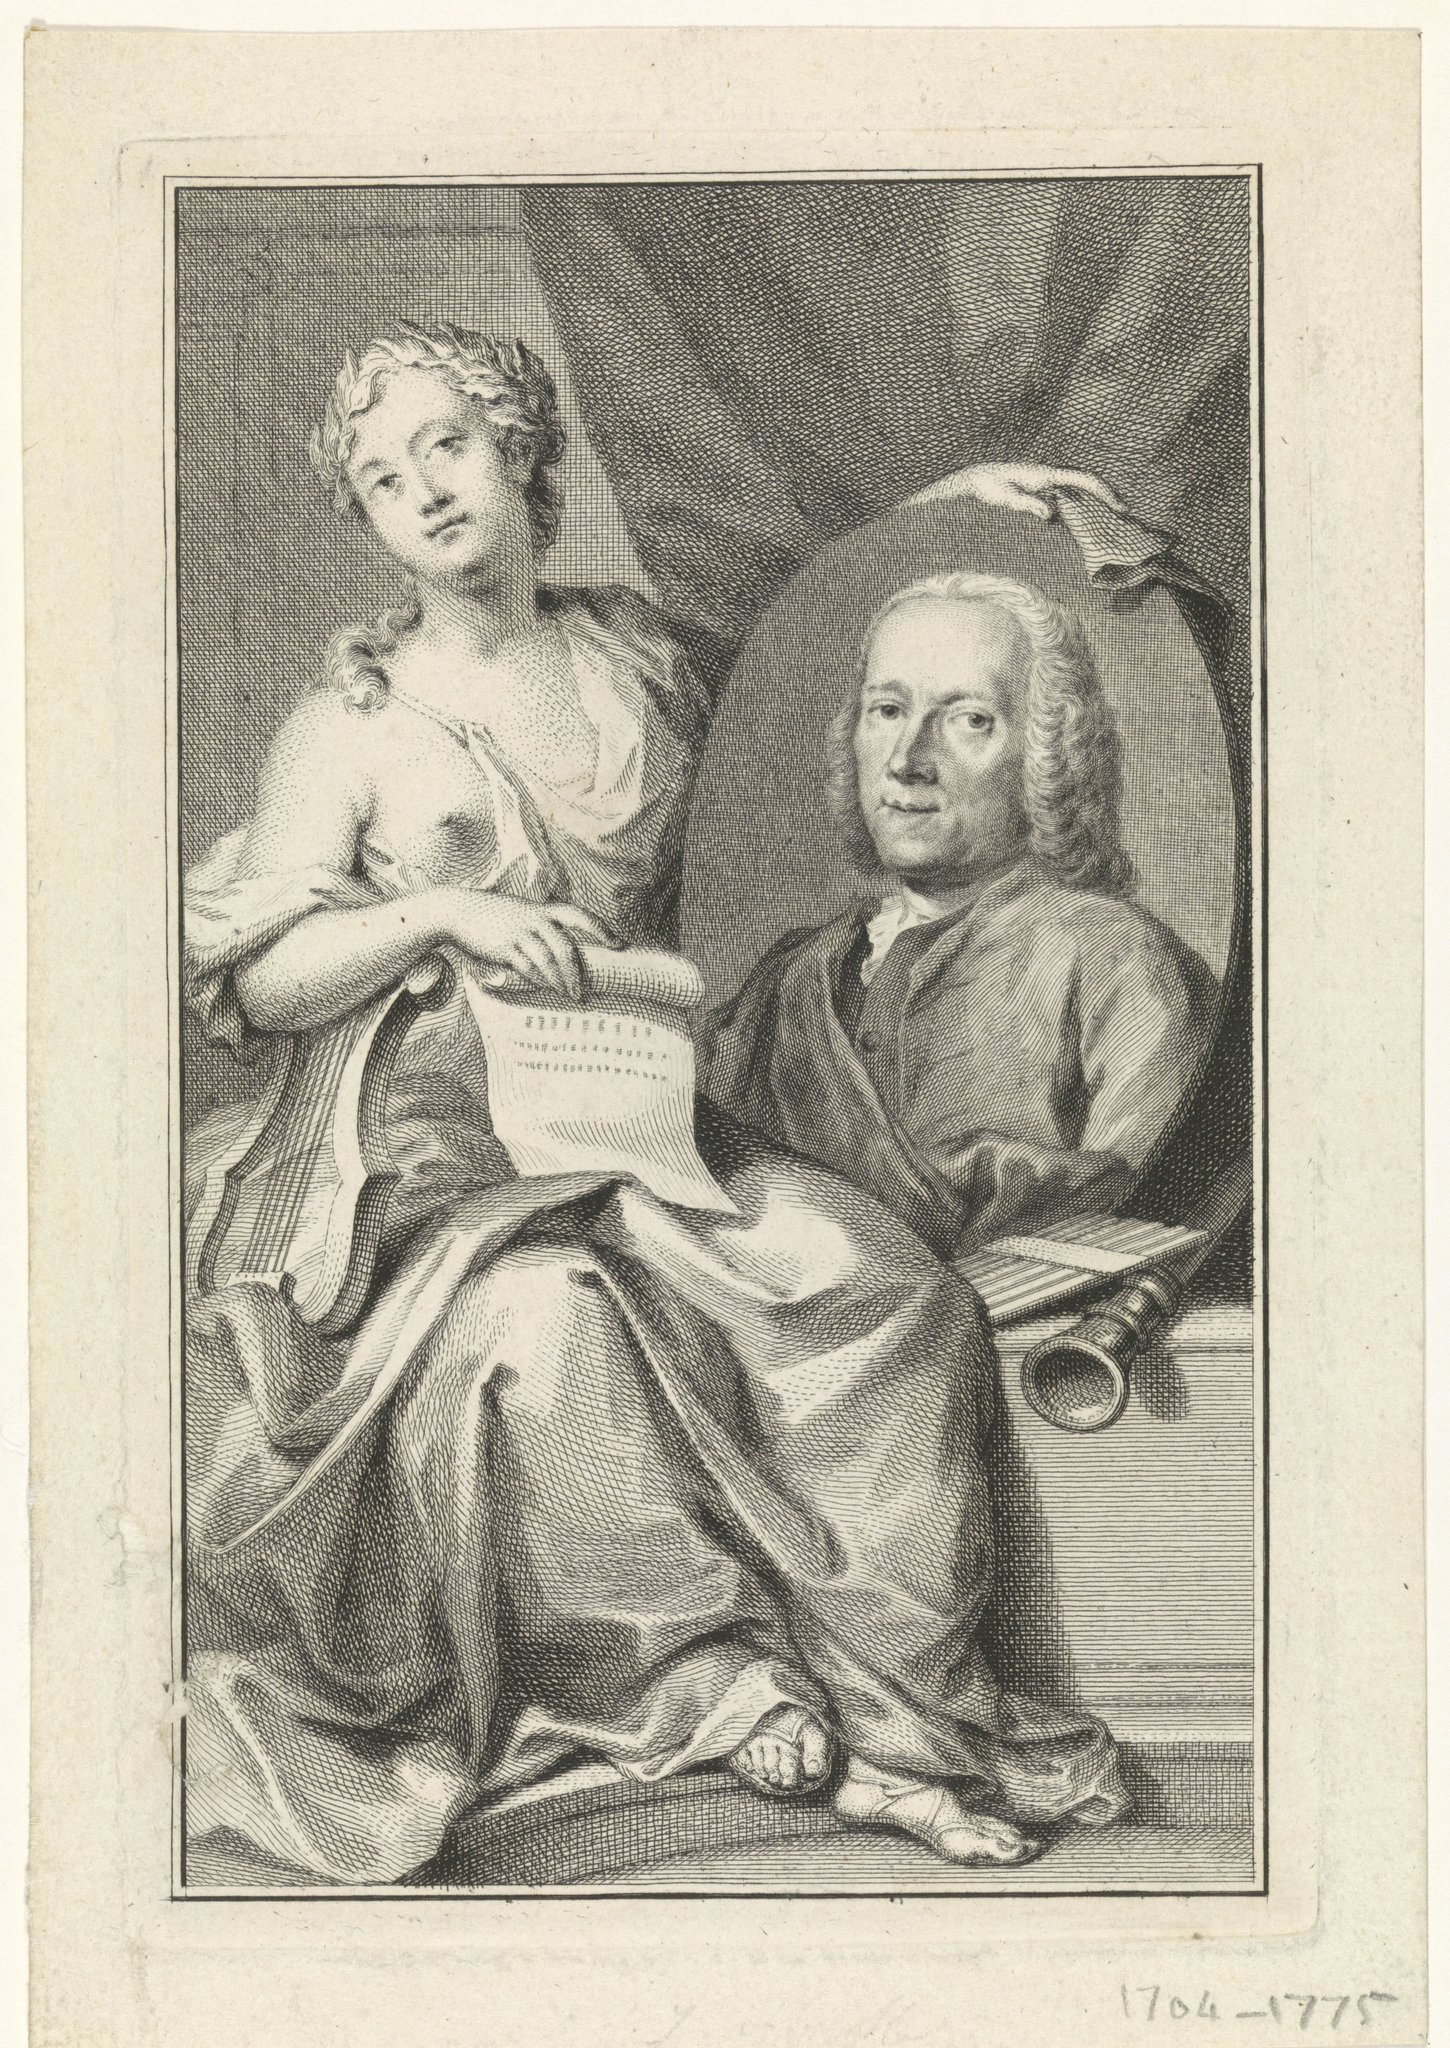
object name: titelprent, frontispice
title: Portret van Jacob Spex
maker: jacob houbraken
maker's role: draughtsman, print maker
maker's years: 1698-1780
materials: paper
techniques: engraving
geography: amsterdam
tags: jacob spex, historical persons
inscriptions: collector's mark: Lugt 240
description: Portret van Jacob Spex in een ovaal medaillon dat wordt vastgehouden door een muze met een lauwerkrans op het hoofd. Tevens houdt zij, zittend op een verhoging, een lier en een blad papier vast. Rechts van het portret andere muziekinstrumenten en op de achtergrond een gordijn.